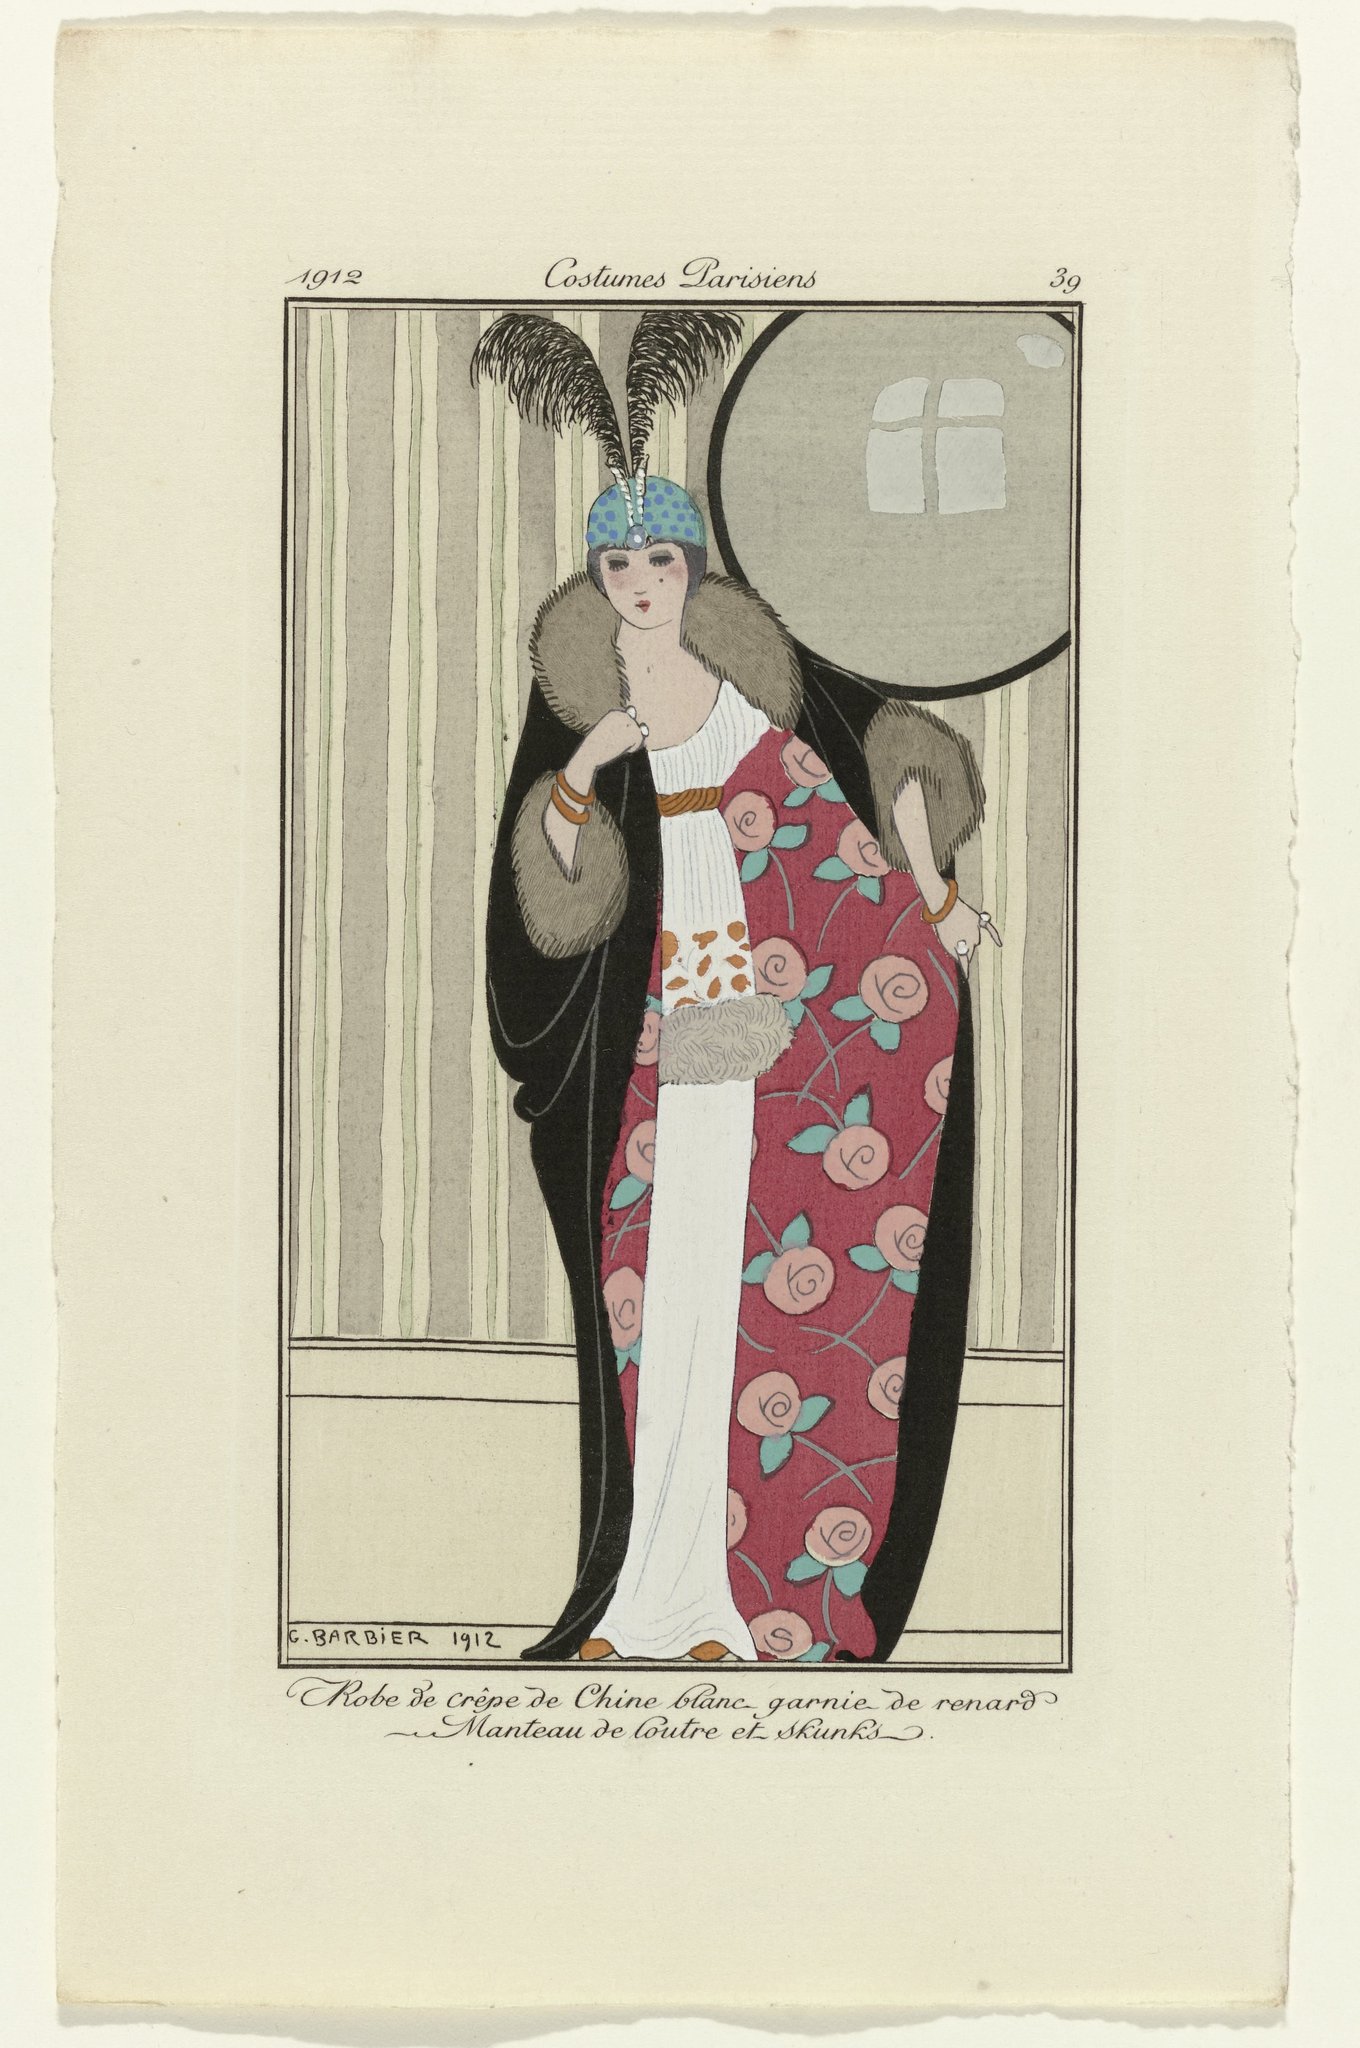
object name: fashion print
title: Journal des Dames et des Modes: Fashion News Journal des Dames et des Modes: the Fashion Illustrators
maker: george barbier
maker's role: designer, draughtsman, painter, print maker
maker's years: 1882-1932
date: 1912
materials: paper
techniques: engraving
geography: paris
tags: fashion plates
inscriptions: caption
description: The Journal des Dames was inspired by the eponymous fashion magazine from the previous century and, like the earlier publication, referred to its illustrations as Costumes Parisiens. These Costumes Parisiens (184 illustrations in total) were drawn in a new, flat, decorative manner by George Barbier, Jan van Brock, Victor Lhuer and other Parisian artists, each with a signature style. Every issue came with two or three separate plates. These showed a wide variety of fashionable apparel, from elegant evening attire to outdoor outfits. A brief caption provides the name of the garment and the material from which it was made, but never the name of a fashion house.